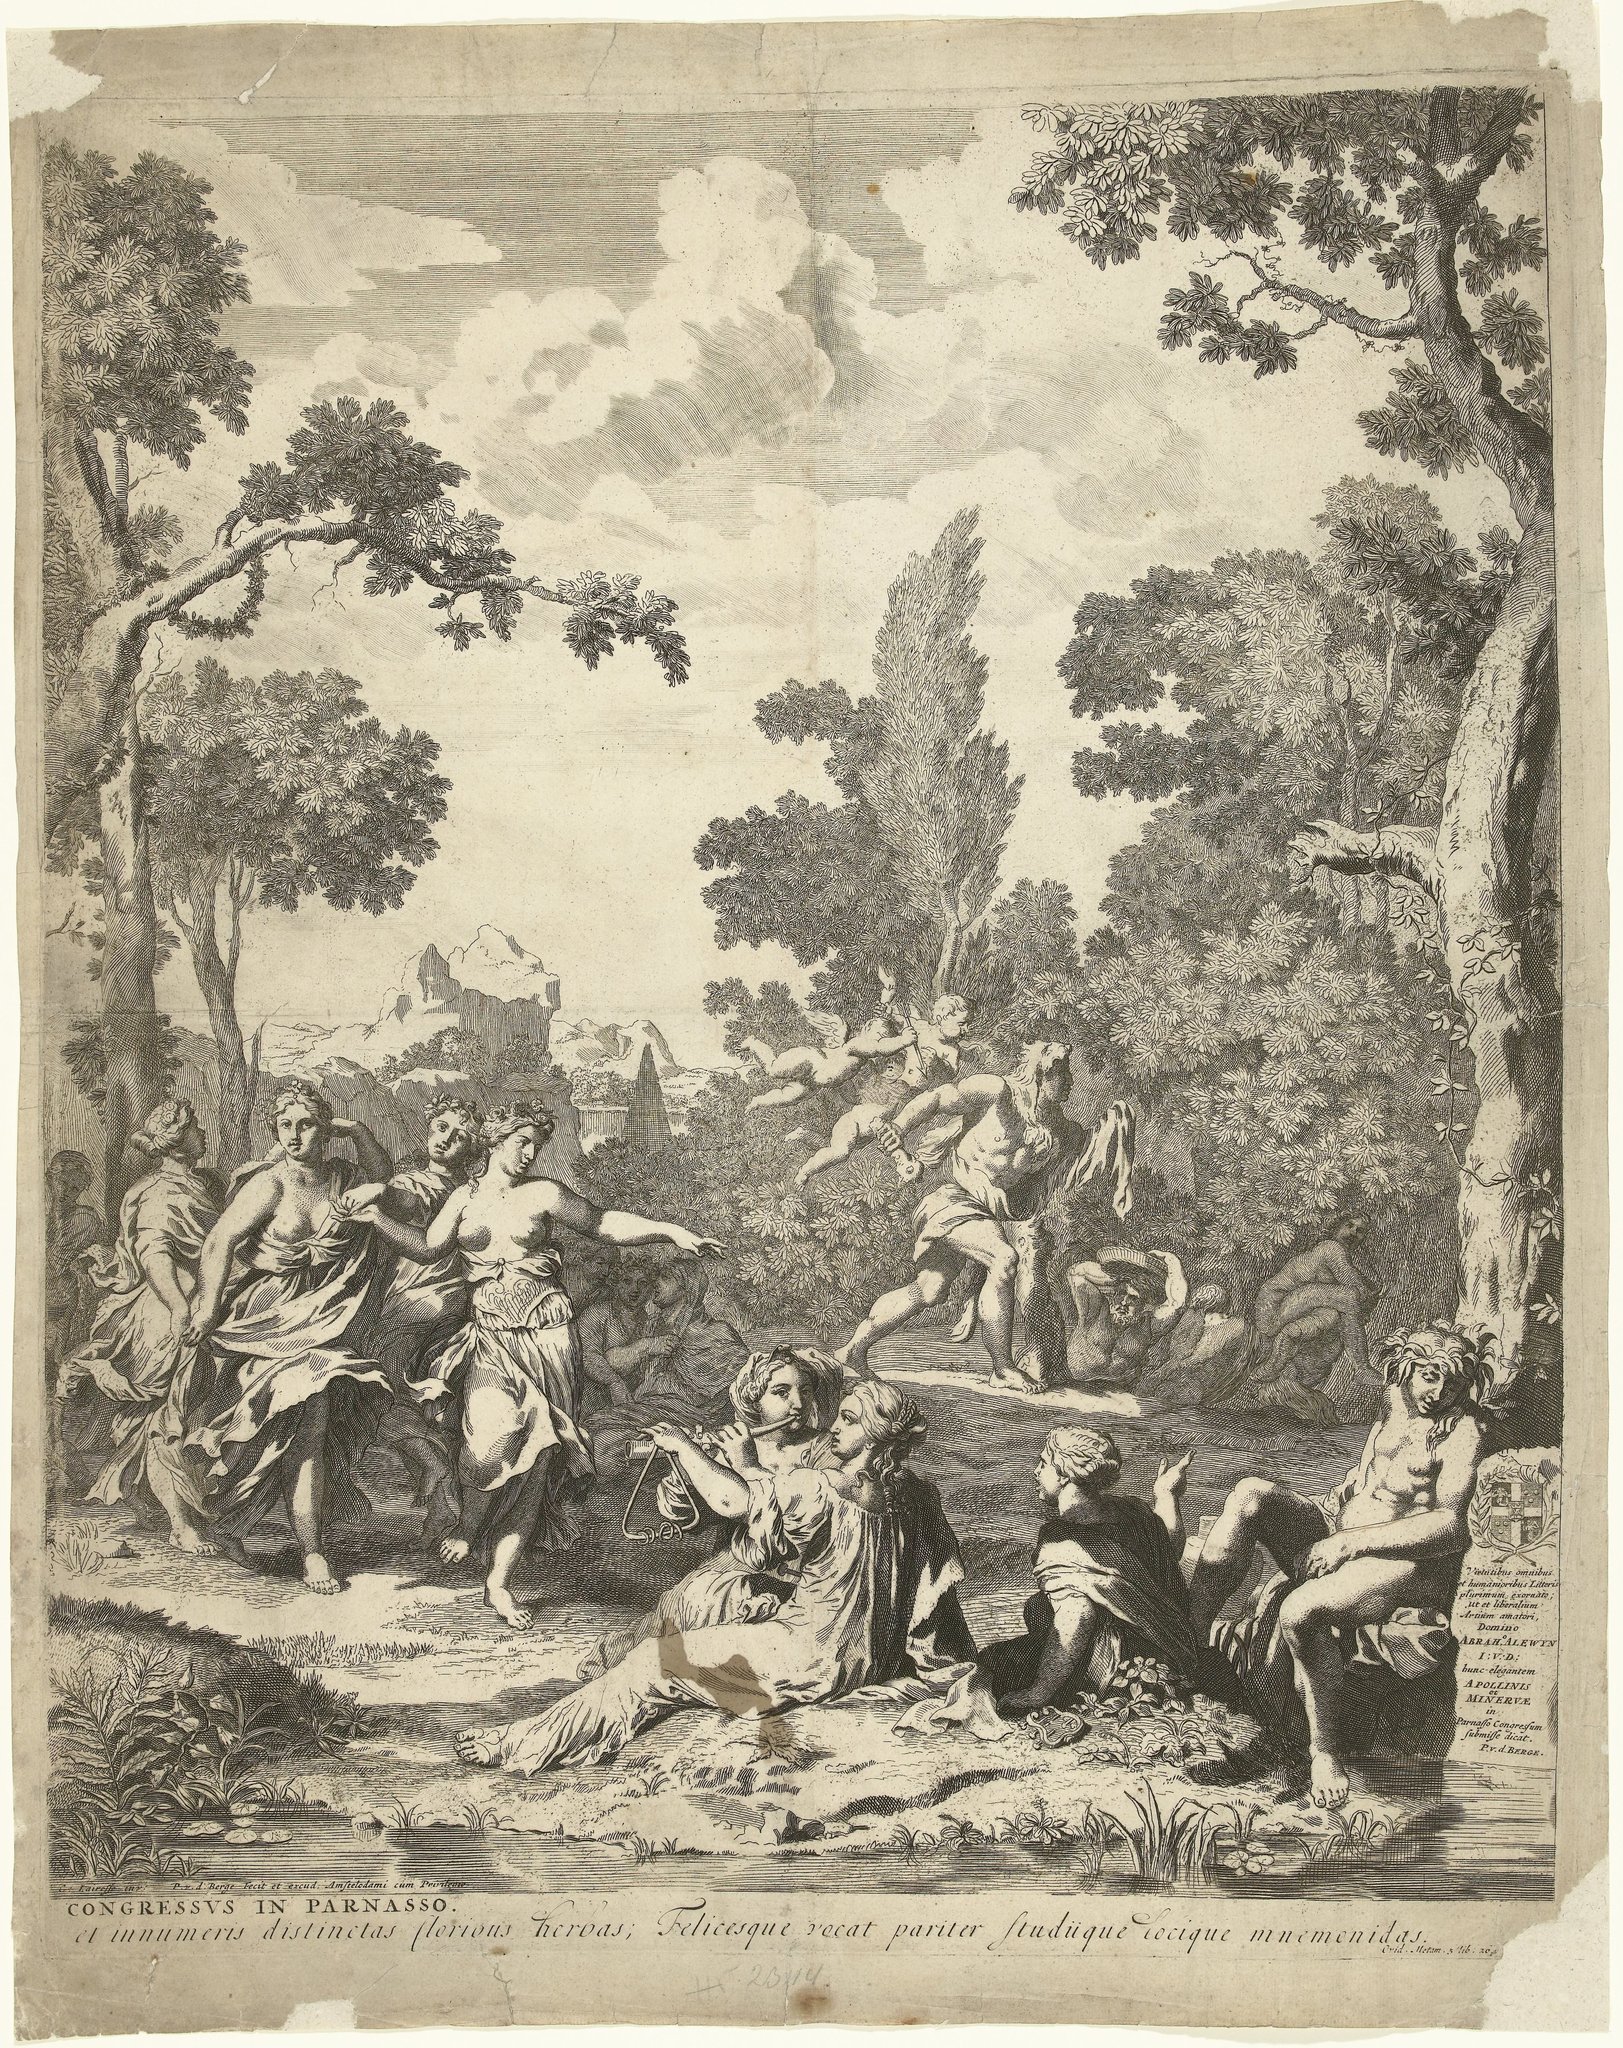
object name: print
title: Minerva bezoekt Apollo en de muzen op de Parnassus, rechter deel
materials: paper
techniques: engraving, etching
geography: amsterdam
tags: (story of) apollo (phoebus), non-aggressive, friendly or neutral activities and relationships of minerva, parnassus, sacred to apollo musagetes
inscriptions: collector's mark: Lugt 2228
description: Rechter deel van een voorstelling met Minerva en Apollo op de bergketen Parnassus, de woonplaats der muzen. De muzen zitten aan het water en maken muziek. Hercules verstoord de rust door met zijn knots en leeuwenhuid door de muzen te rennen.